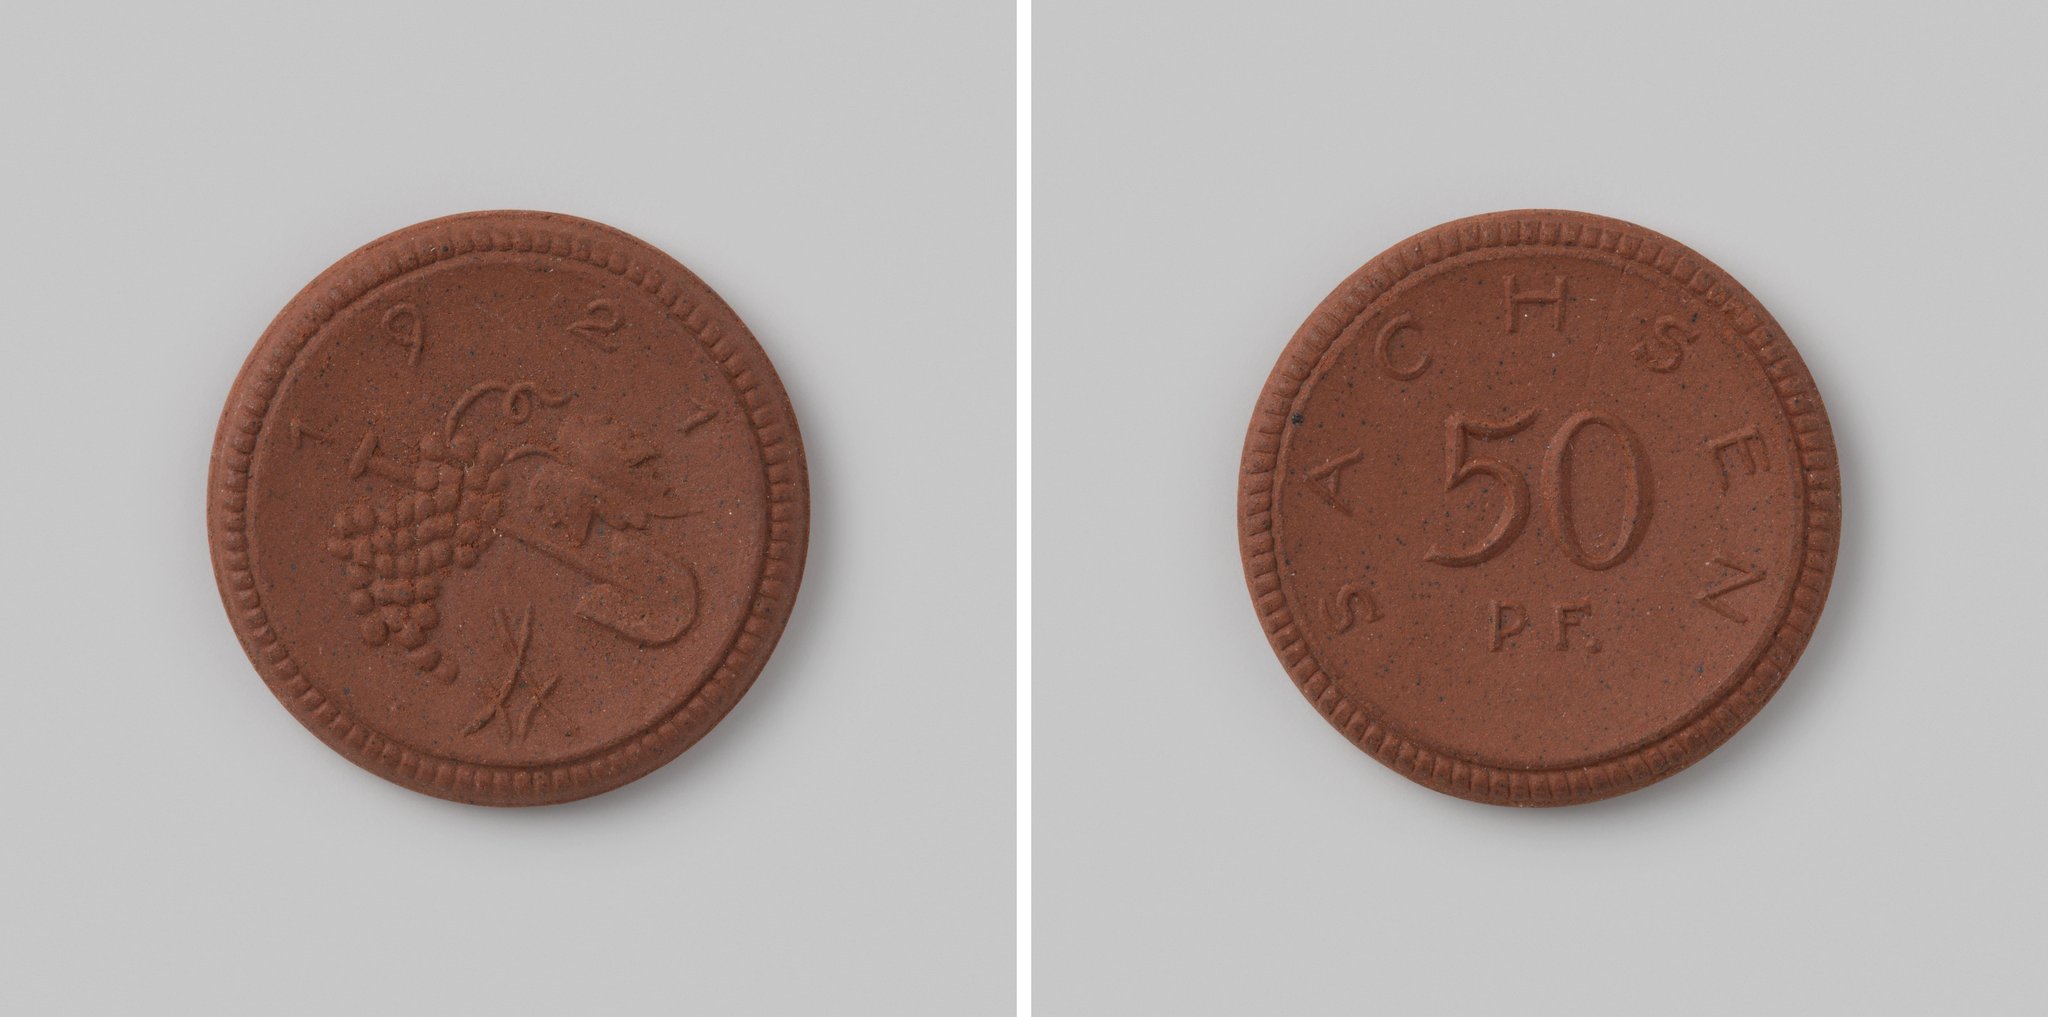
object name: vijftig pfennig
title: 50 pfennig uit Duitsland, Saksen, 1921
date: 1921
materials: porcelain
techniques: casting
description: Porseleinen pseudomunt. Voorzijde: schep met op steel wijnrank, waarboven jaartal. Keerzijde: waarde-aanduiding in twee regels. Daaromheen land-aanduiding. Gladde rand.